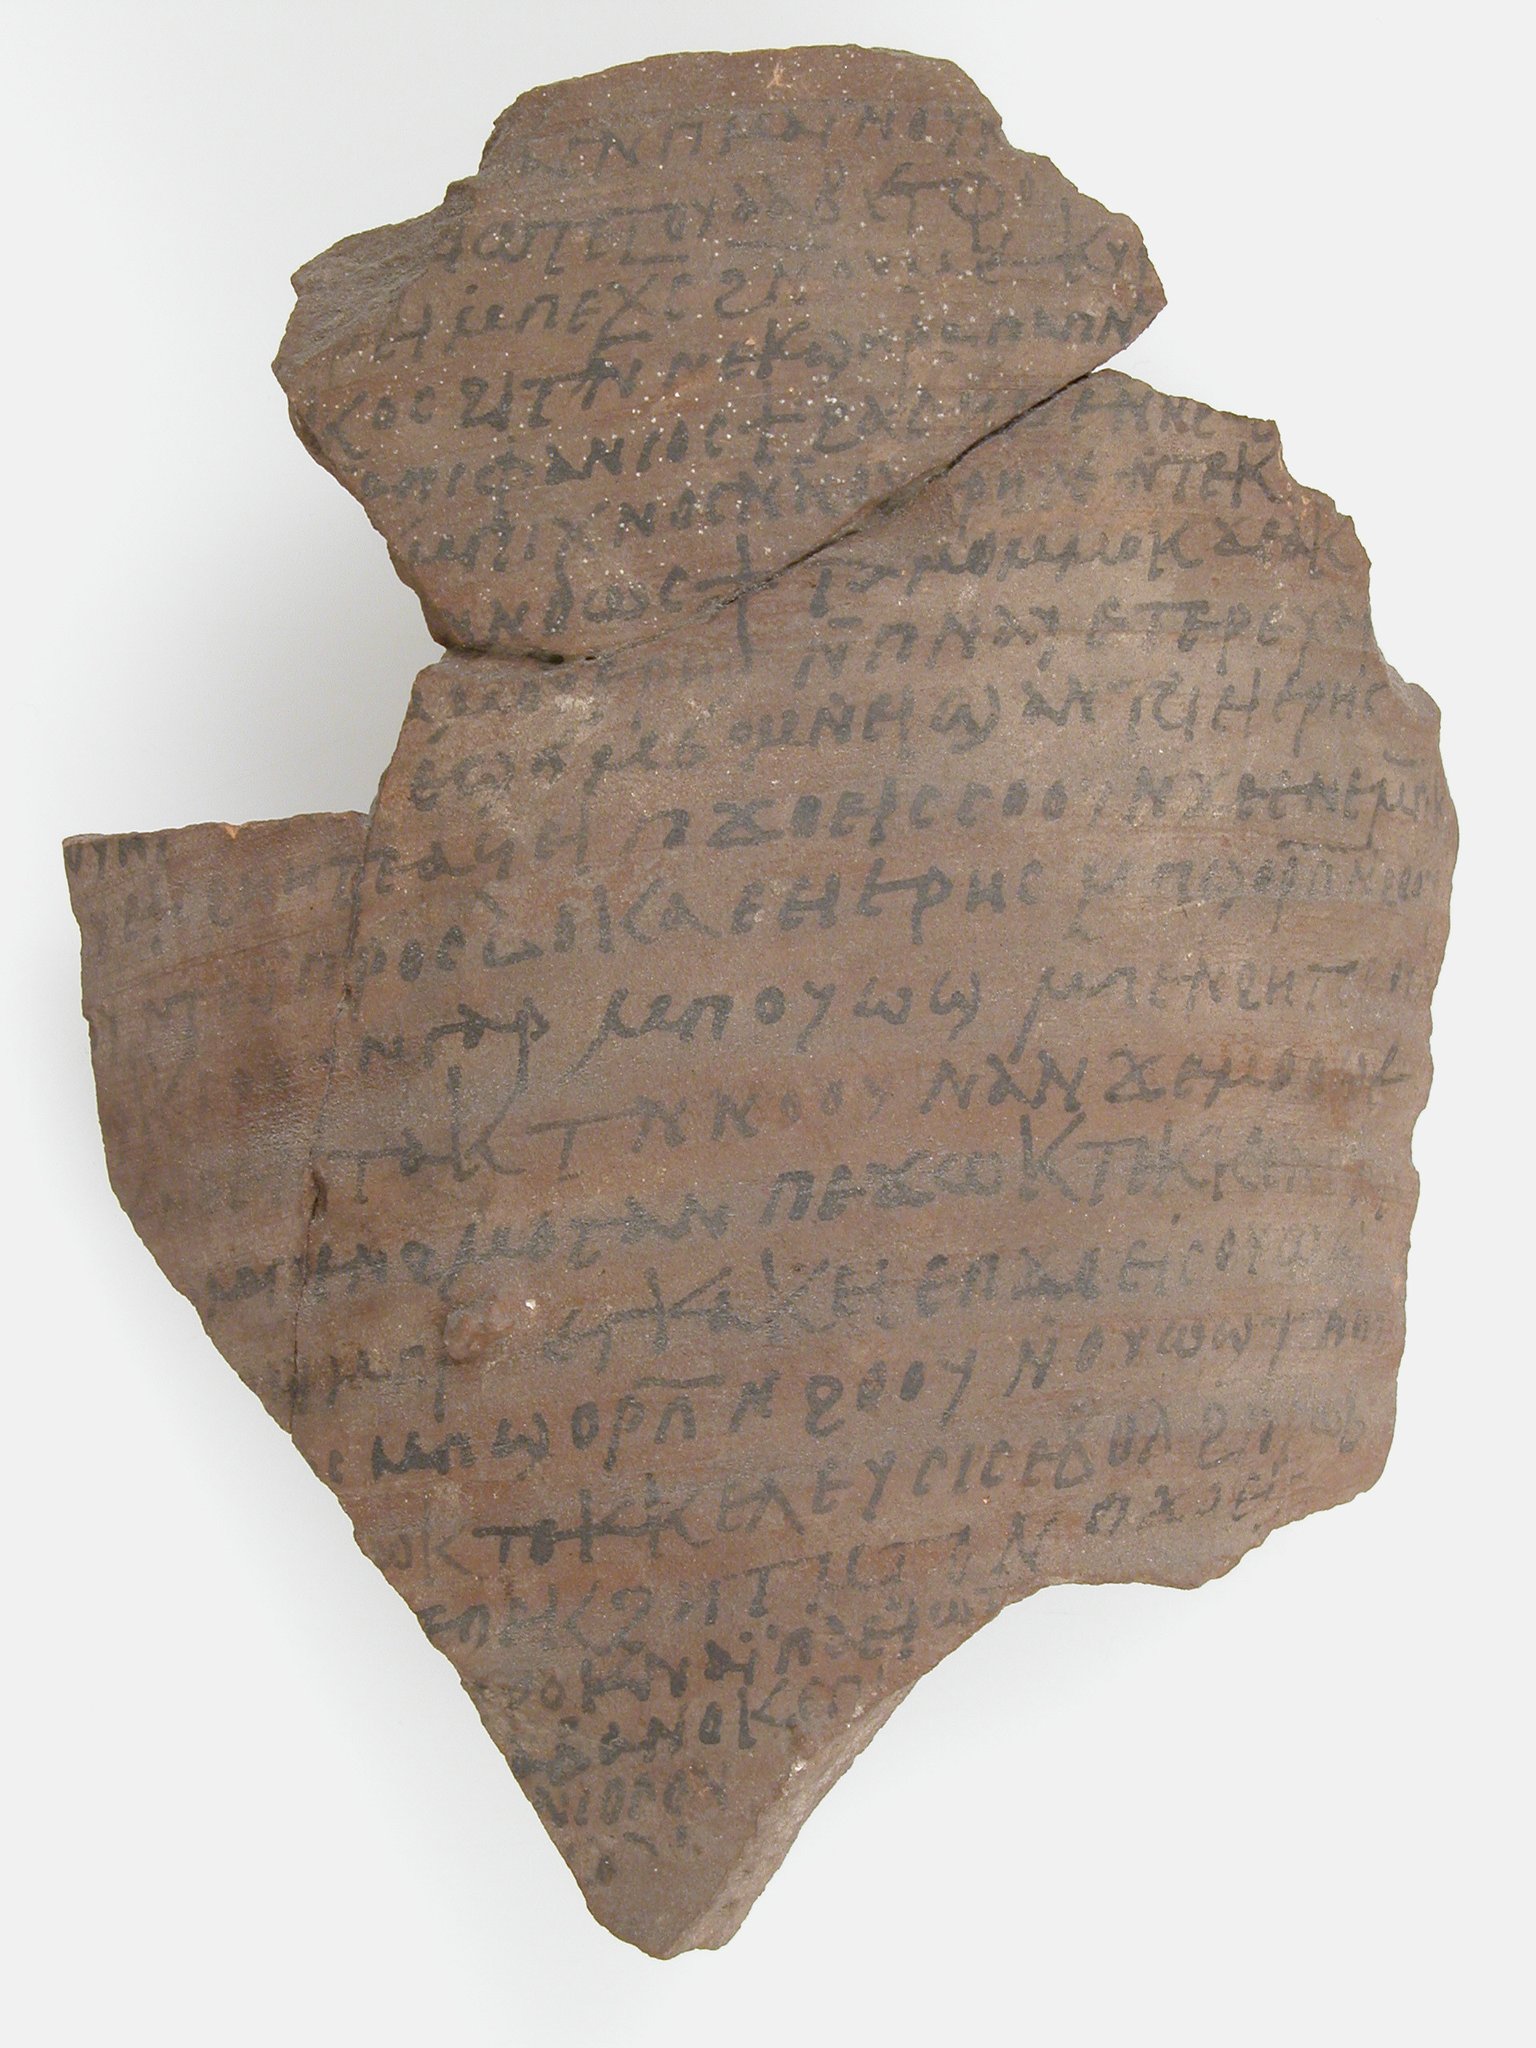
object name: ostrakon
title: Ostrakon with a Letter from Papnoute and Epiphanius to Cyriacus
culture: coptic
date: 600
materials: ink, pottery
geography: egypt